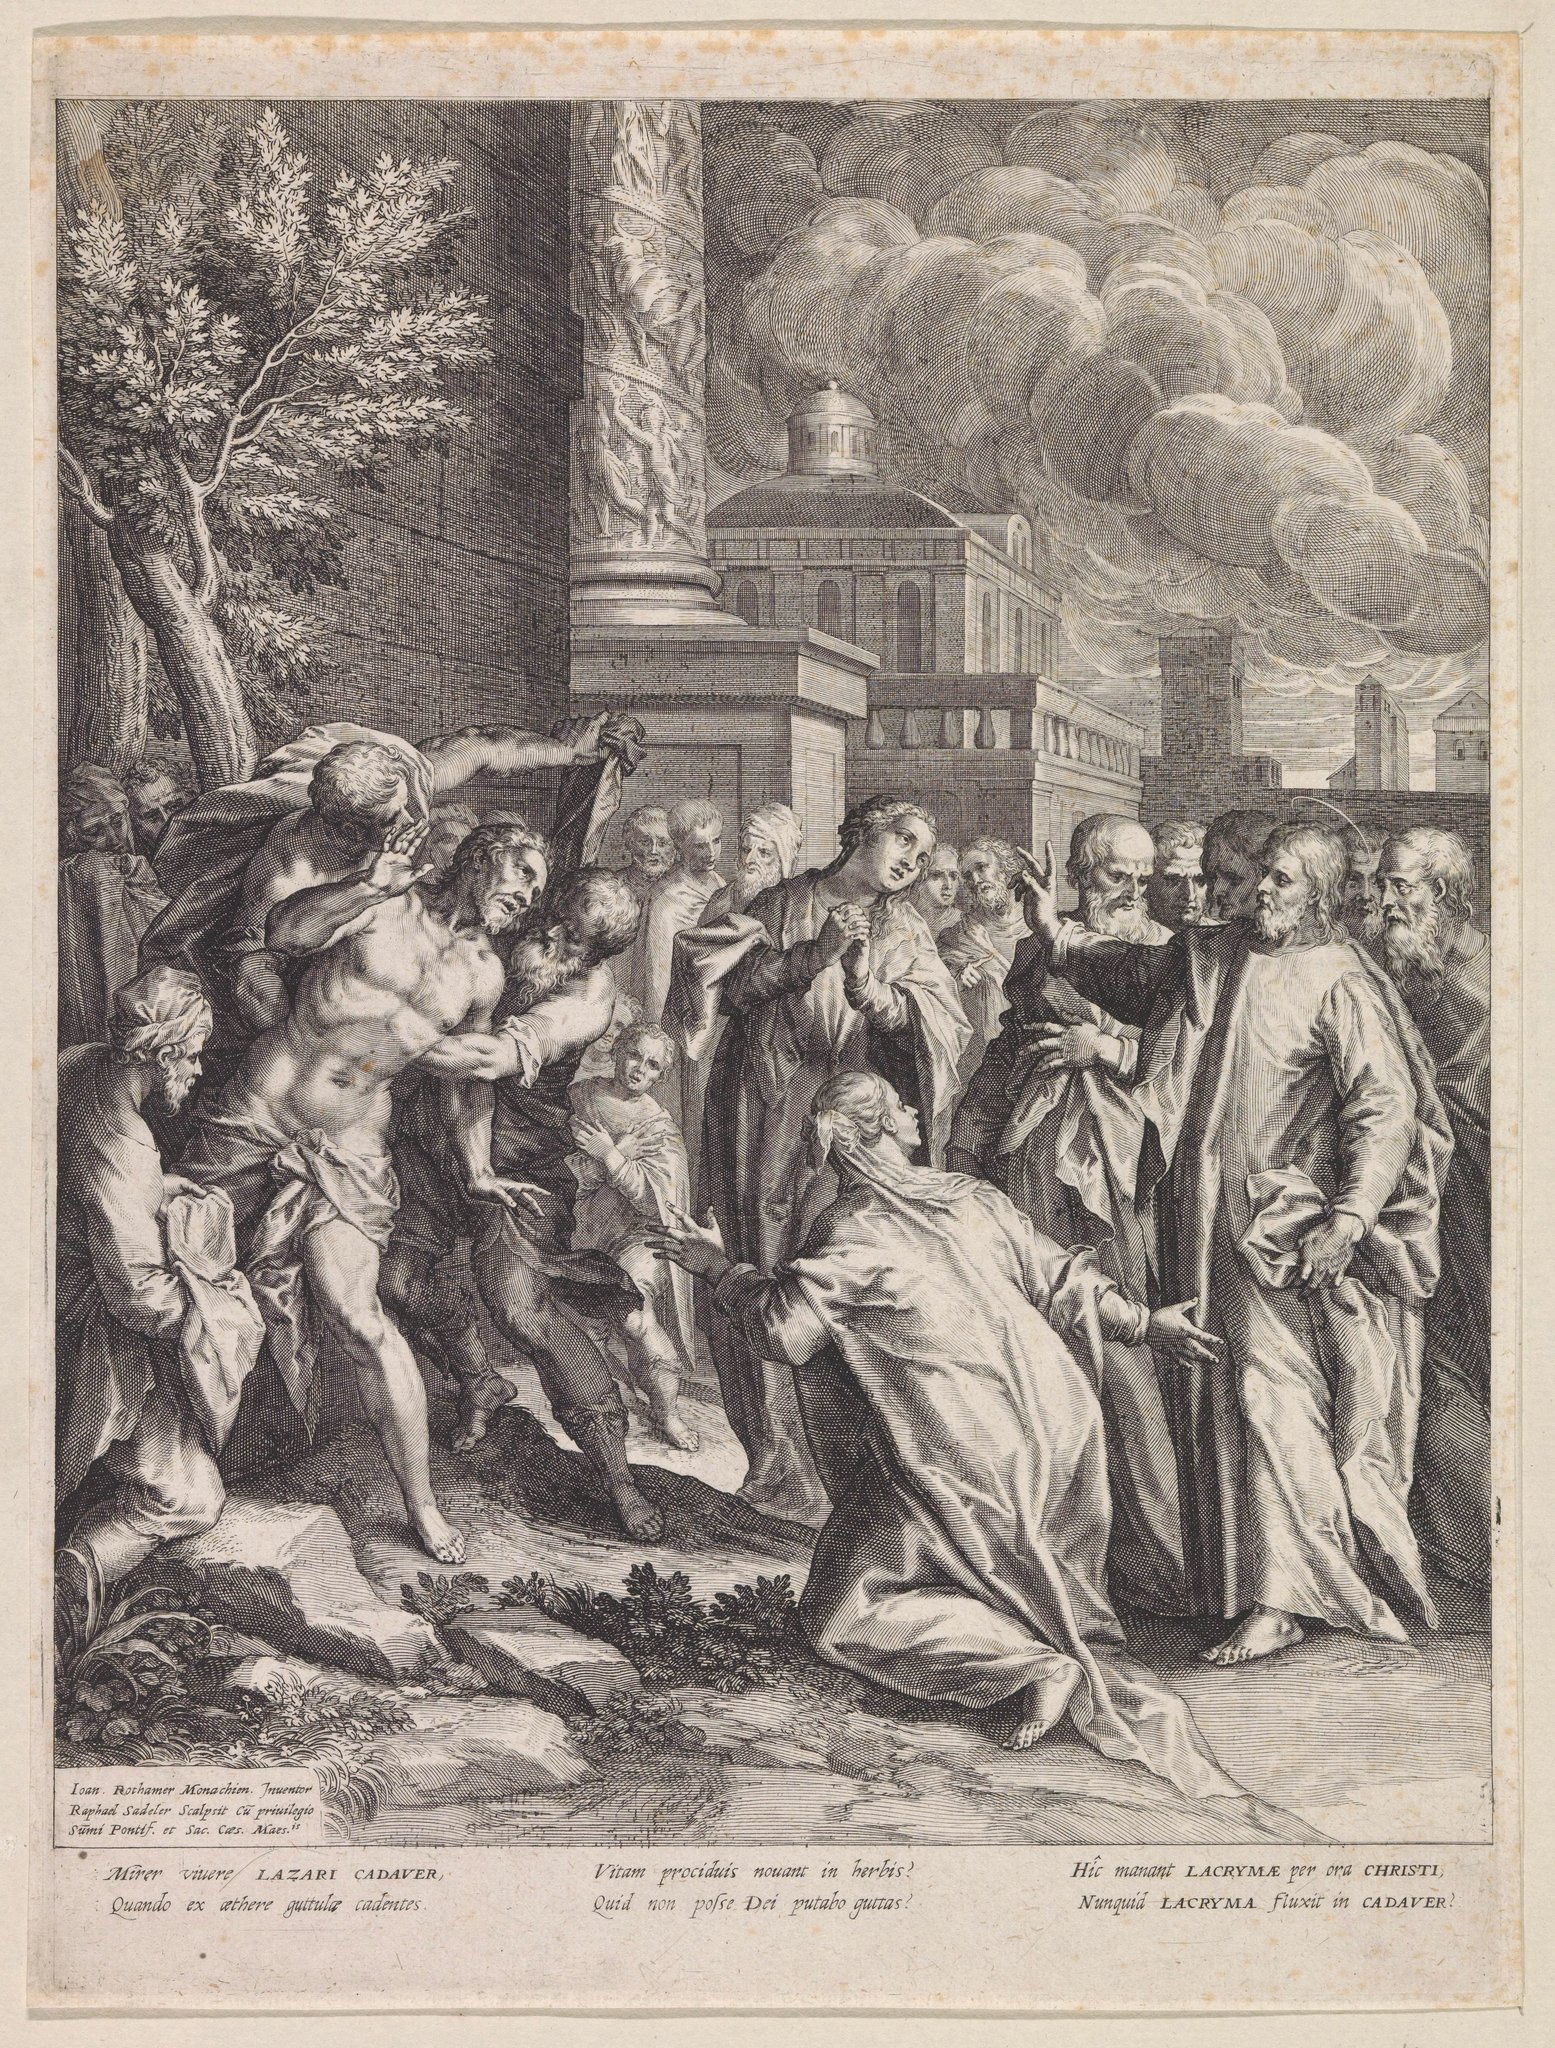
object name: print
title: Opwekking van Lazarus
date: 1598-1604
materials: paper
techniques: engraving, etching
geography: munich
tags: the raising of lazarus ('lazarus, come out')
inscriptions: collector's mark: Lugt 240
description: Op bevel van Christus staat Lazarus op uit de dood. Rondom hen is een menigte verzameld.